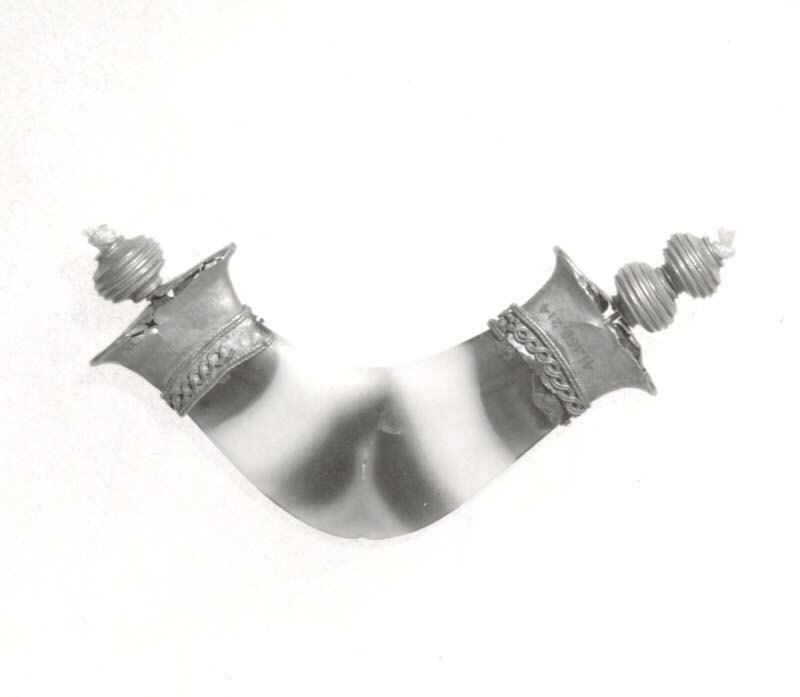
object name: bead and pendant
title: Part of a necklace: pendant and beads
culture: isin-larsa–old babylonian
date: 1900-1701 BCE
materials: stone, gold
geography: southern mesopotamia